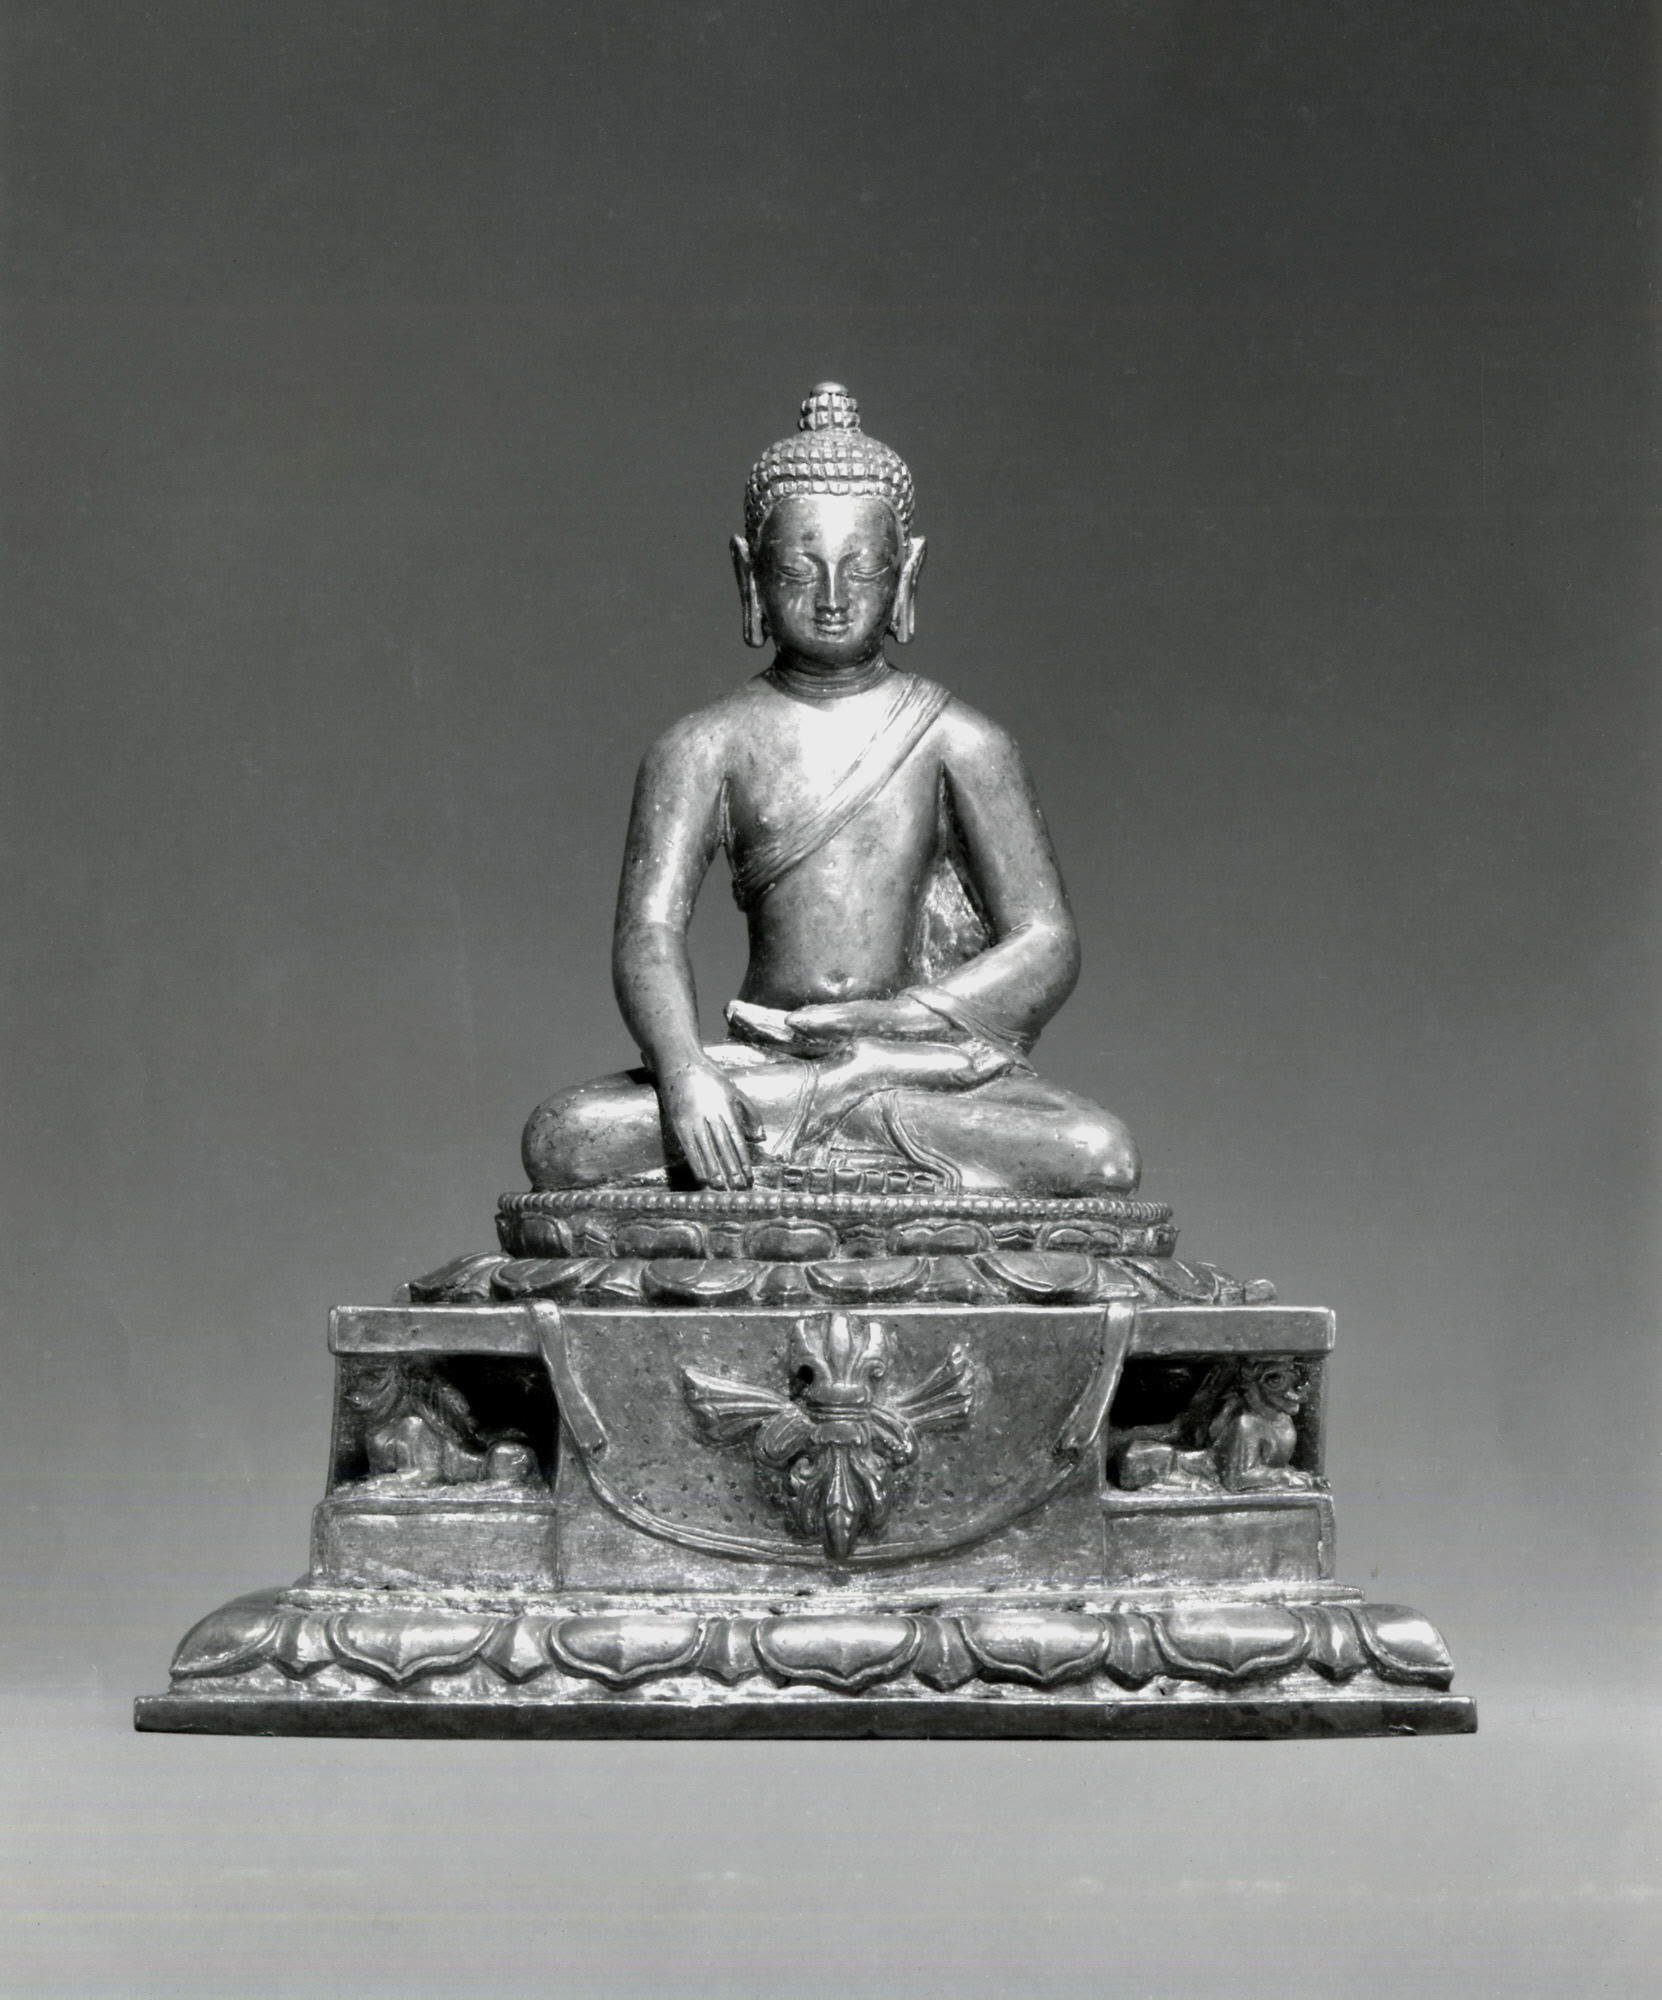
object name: figure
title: Akshobhya, the Transcendent Buddha of the East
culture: nepali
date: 1101-1200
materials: copper, gold paint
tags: buddhism,akshobhya